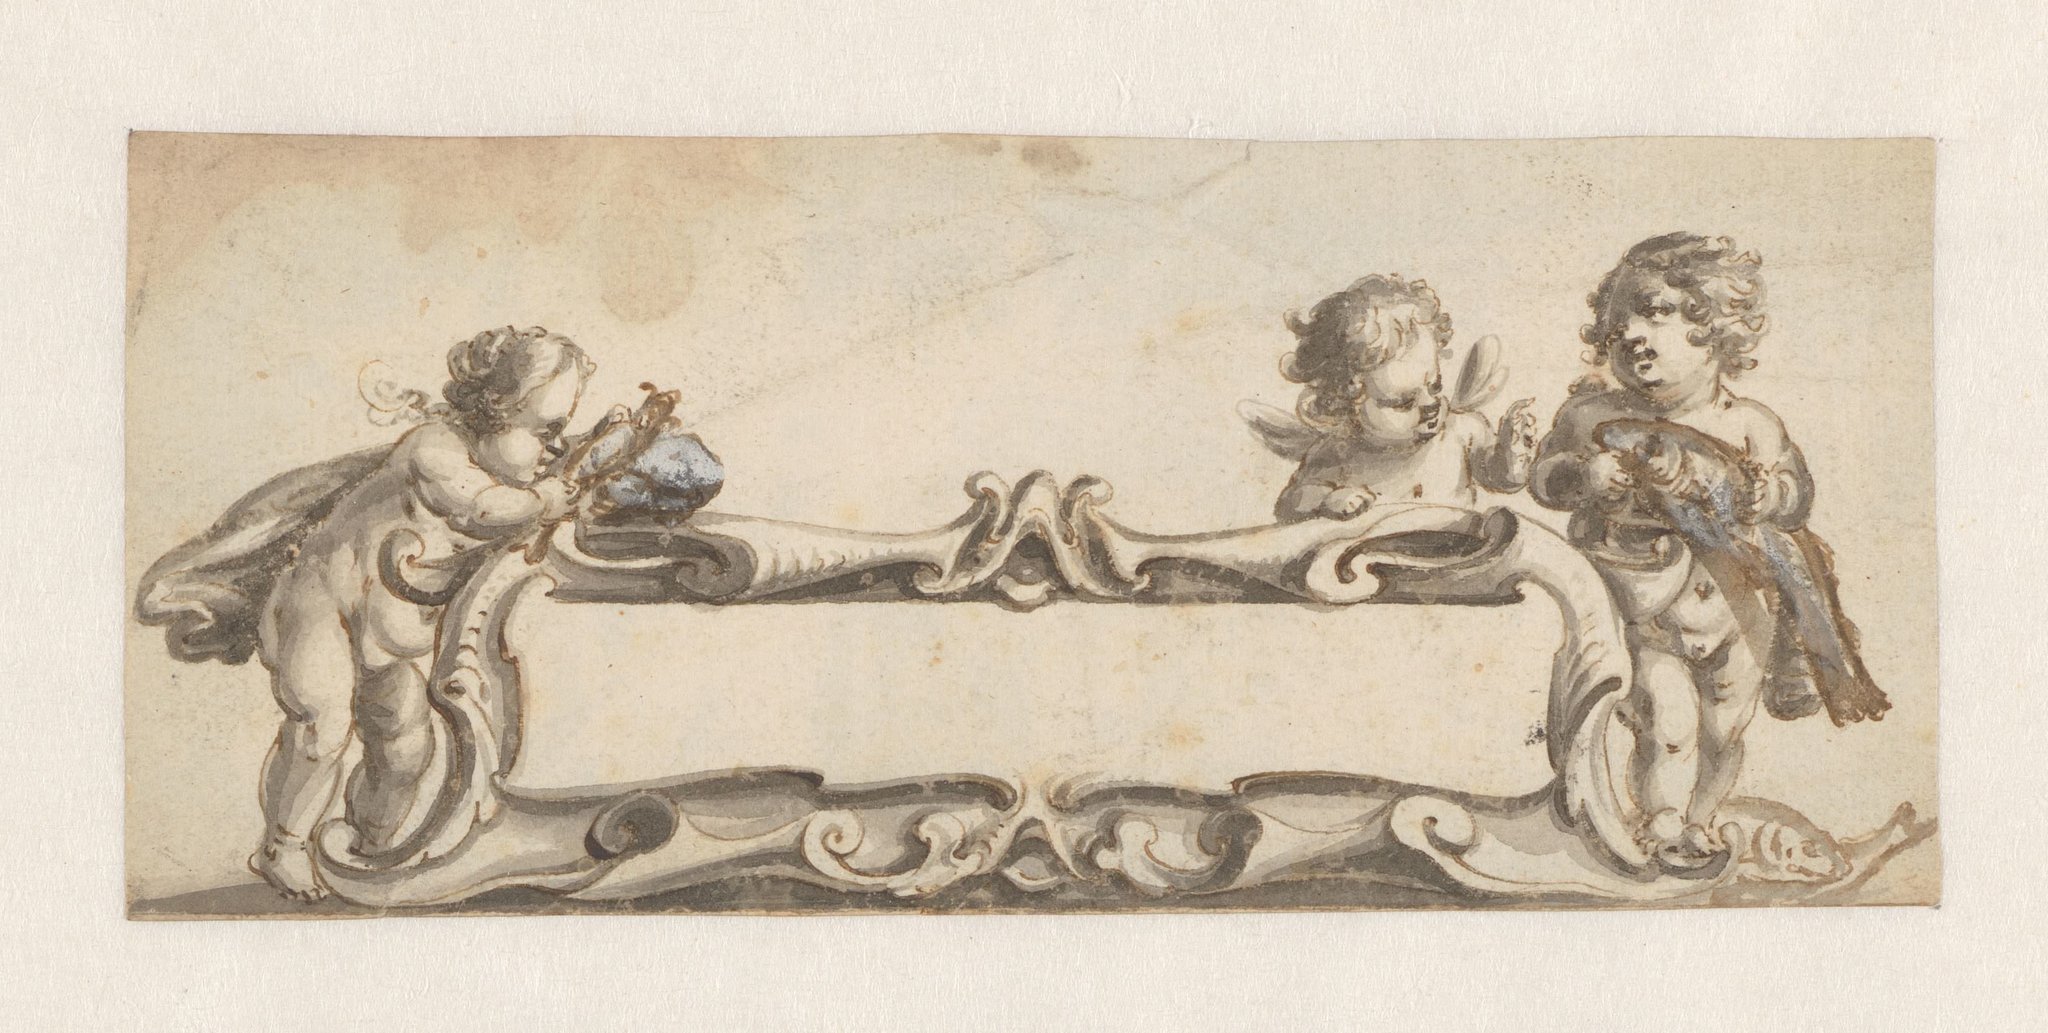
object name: drawing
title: Langwerpige cartouche met drie putti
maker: pieter jansz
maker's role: draughtsman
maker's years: 1602-1672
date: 1657-1662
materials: paint, ink, paper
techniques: brush, pen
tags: fishes, ornament ~ cartouche, cupids: 'amores', 'amoretti', 'putti'